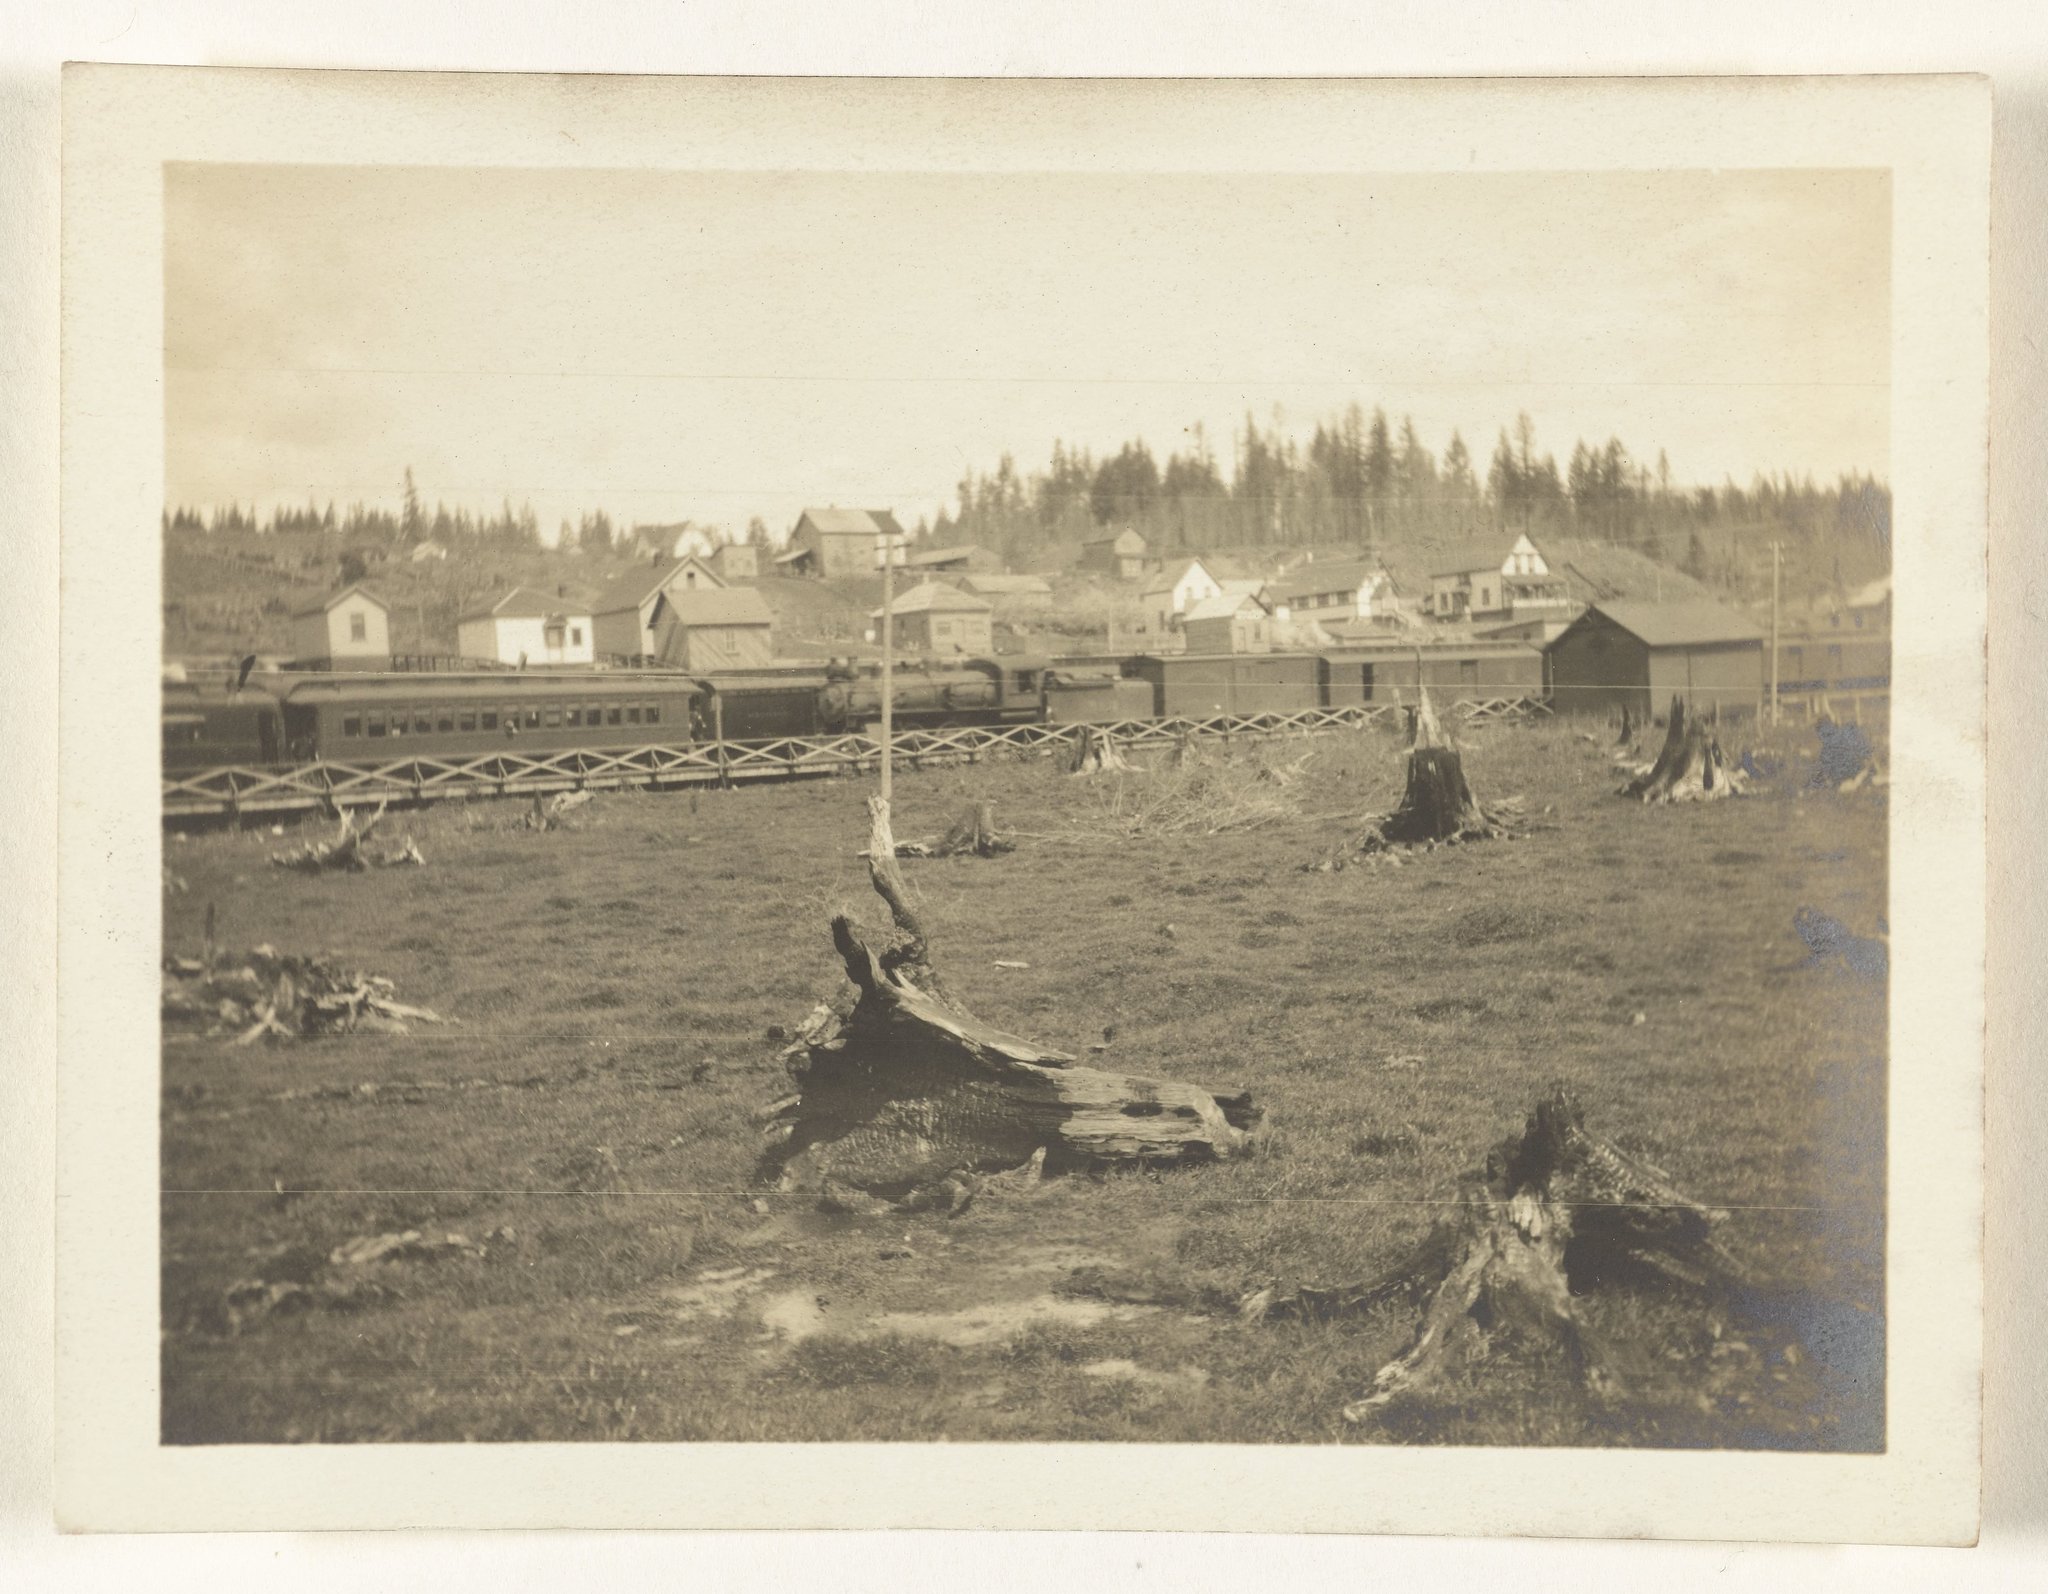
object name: photograph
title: The far west, Mission Junction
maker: geldolph adriaan kessler (dolph)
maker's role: fotograaf, industrieel, voetballer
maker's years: 1884-1945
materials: cardboard, photographic support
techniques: gelatin silver print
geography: los angeles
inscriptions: title: ‘The far west Mission junction’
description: Vermoedelijk het gebied rond het station Mission Junction in Los Angeles in California. Onderdeel van het fotoalbum van Dolph Kessler met opnamen die hij maakte tijdens zijn verblijf in Engeland en op een wereldreis die hij als secretaris van Henri Deterding (directeur Koninklijke Olie) ondernam naar Nederlands-Indië, Japan, China en de Verenigde Staten, tussen 1906 en 1908.